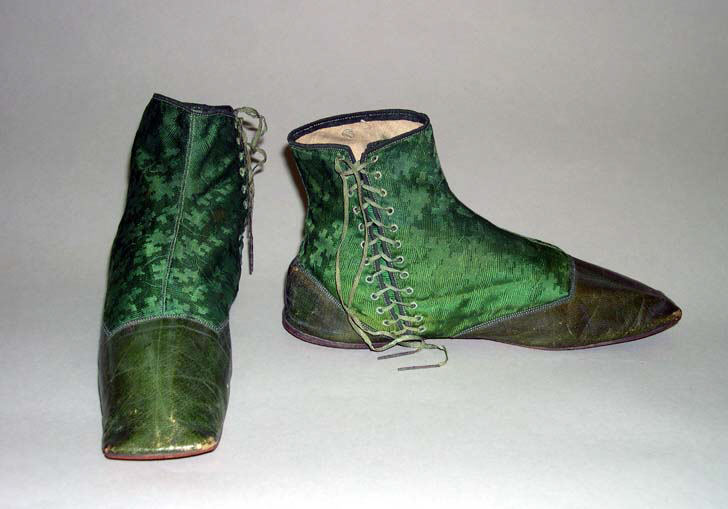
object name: shoe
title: Shoes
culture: american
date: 1830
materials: leather, silk